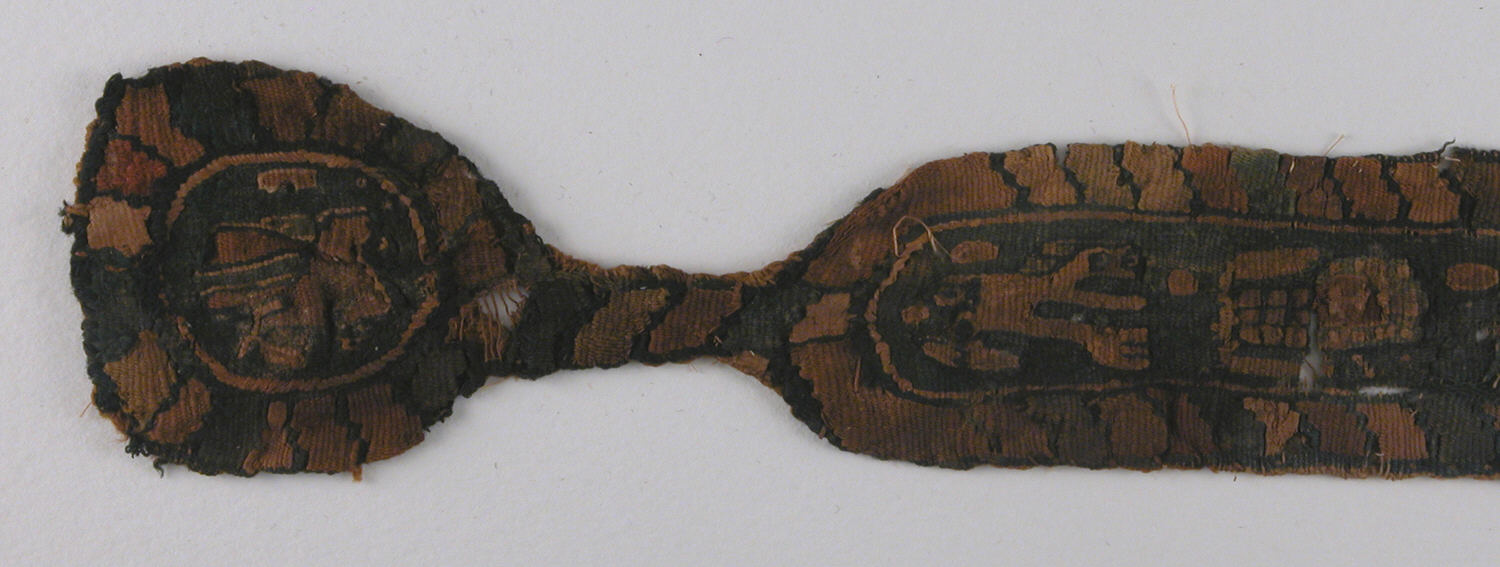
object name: shoulder band fragment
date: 501-800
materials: wool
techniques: weave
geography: egypt